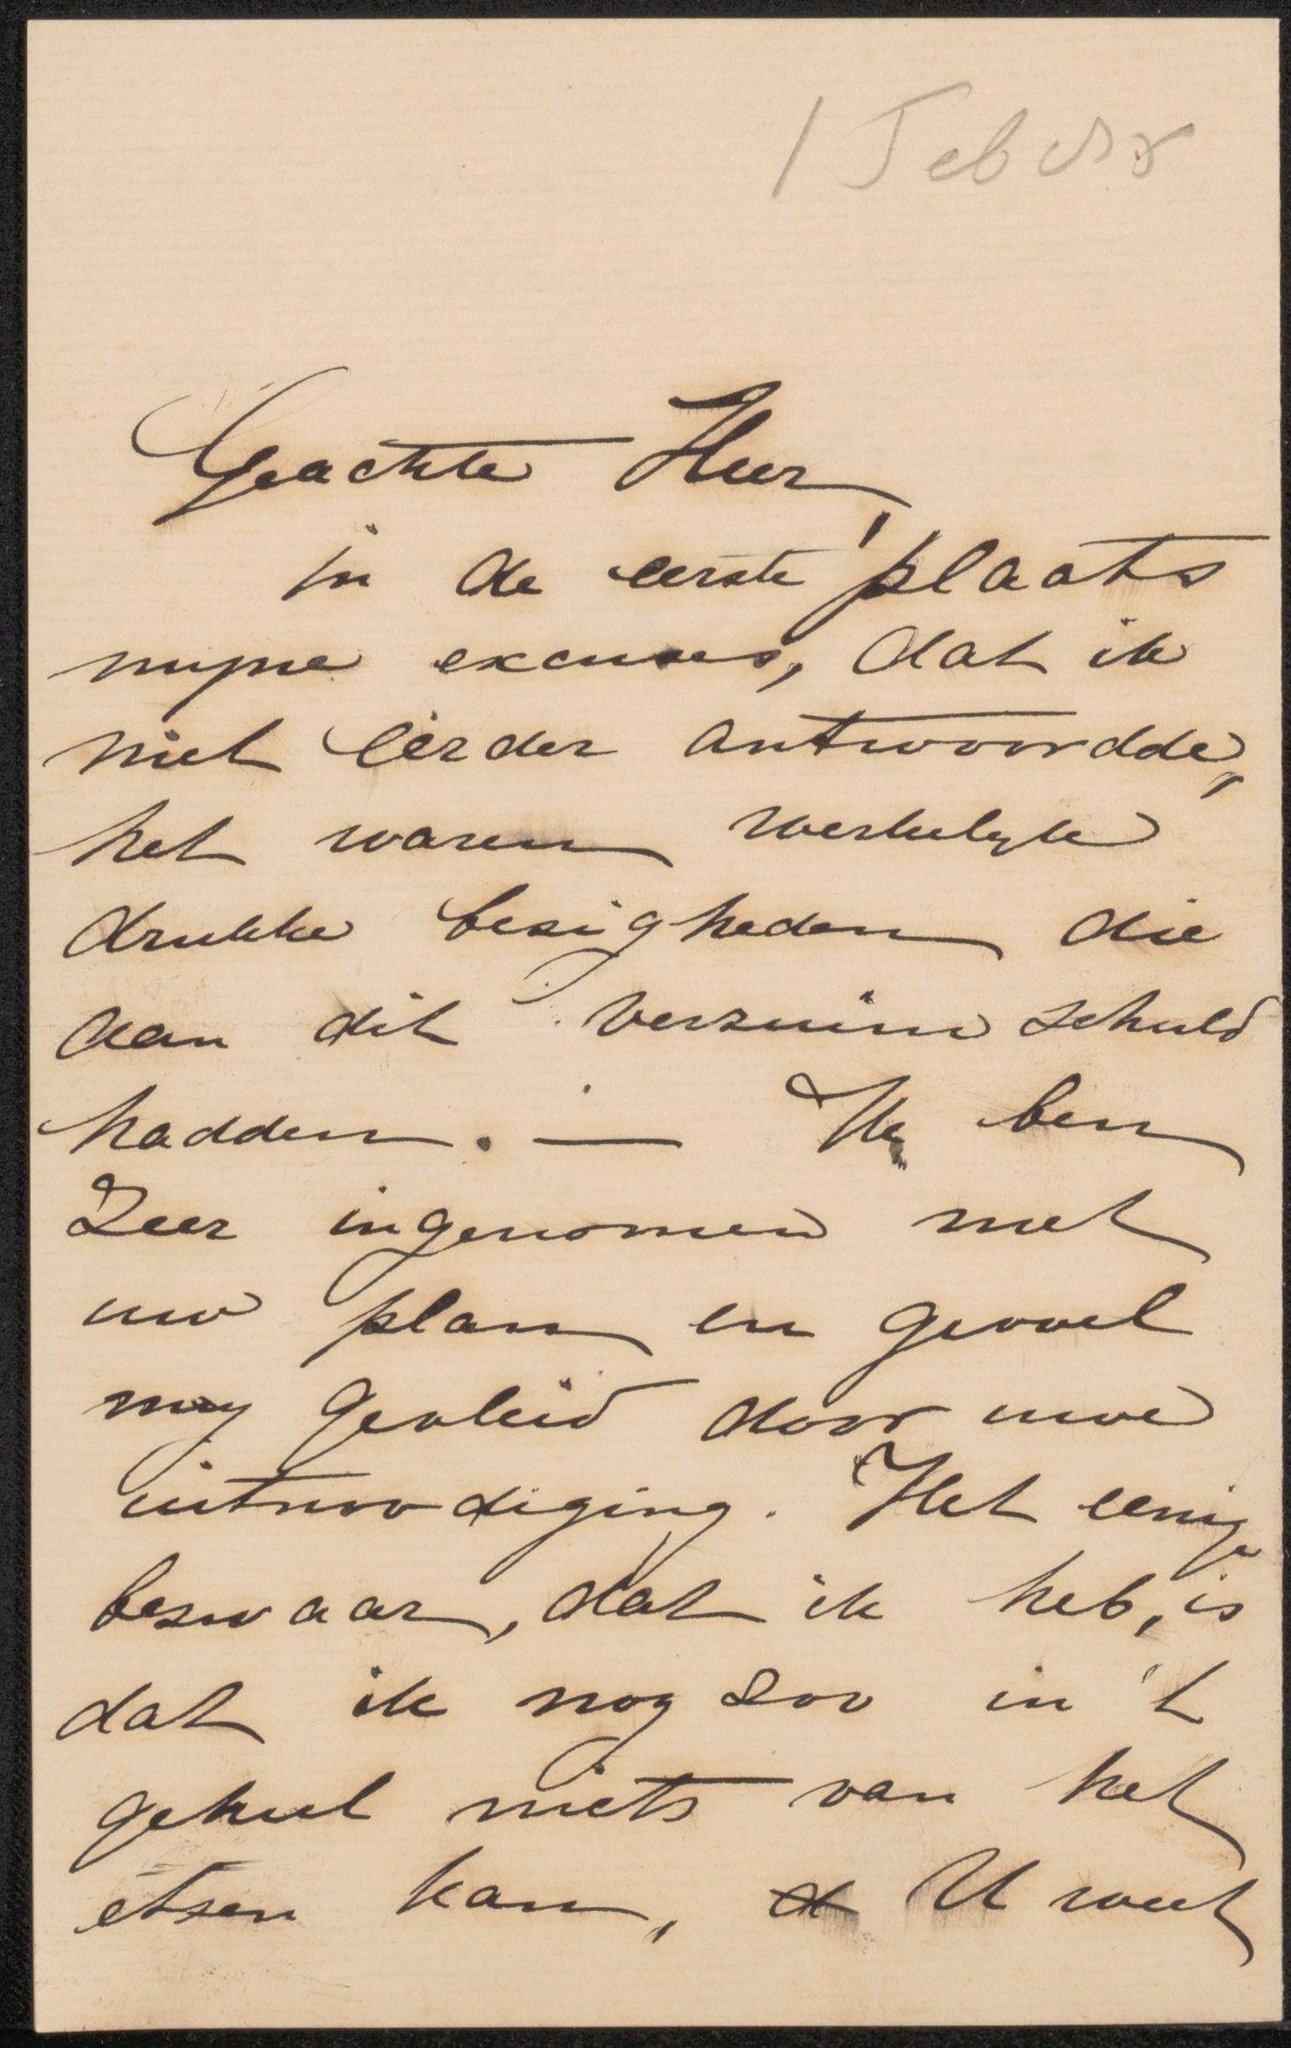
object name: letter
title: Brief aan Jan Veth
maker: wally moes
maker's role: draughtsman, print maker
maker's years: 1856-1918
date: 1802-1885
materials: ink, paper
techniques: pen, writing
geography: amsterdam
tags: dordrecht, painter, designer, jan veth, the graphic arts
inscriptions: collector's mark: ‘RPK’